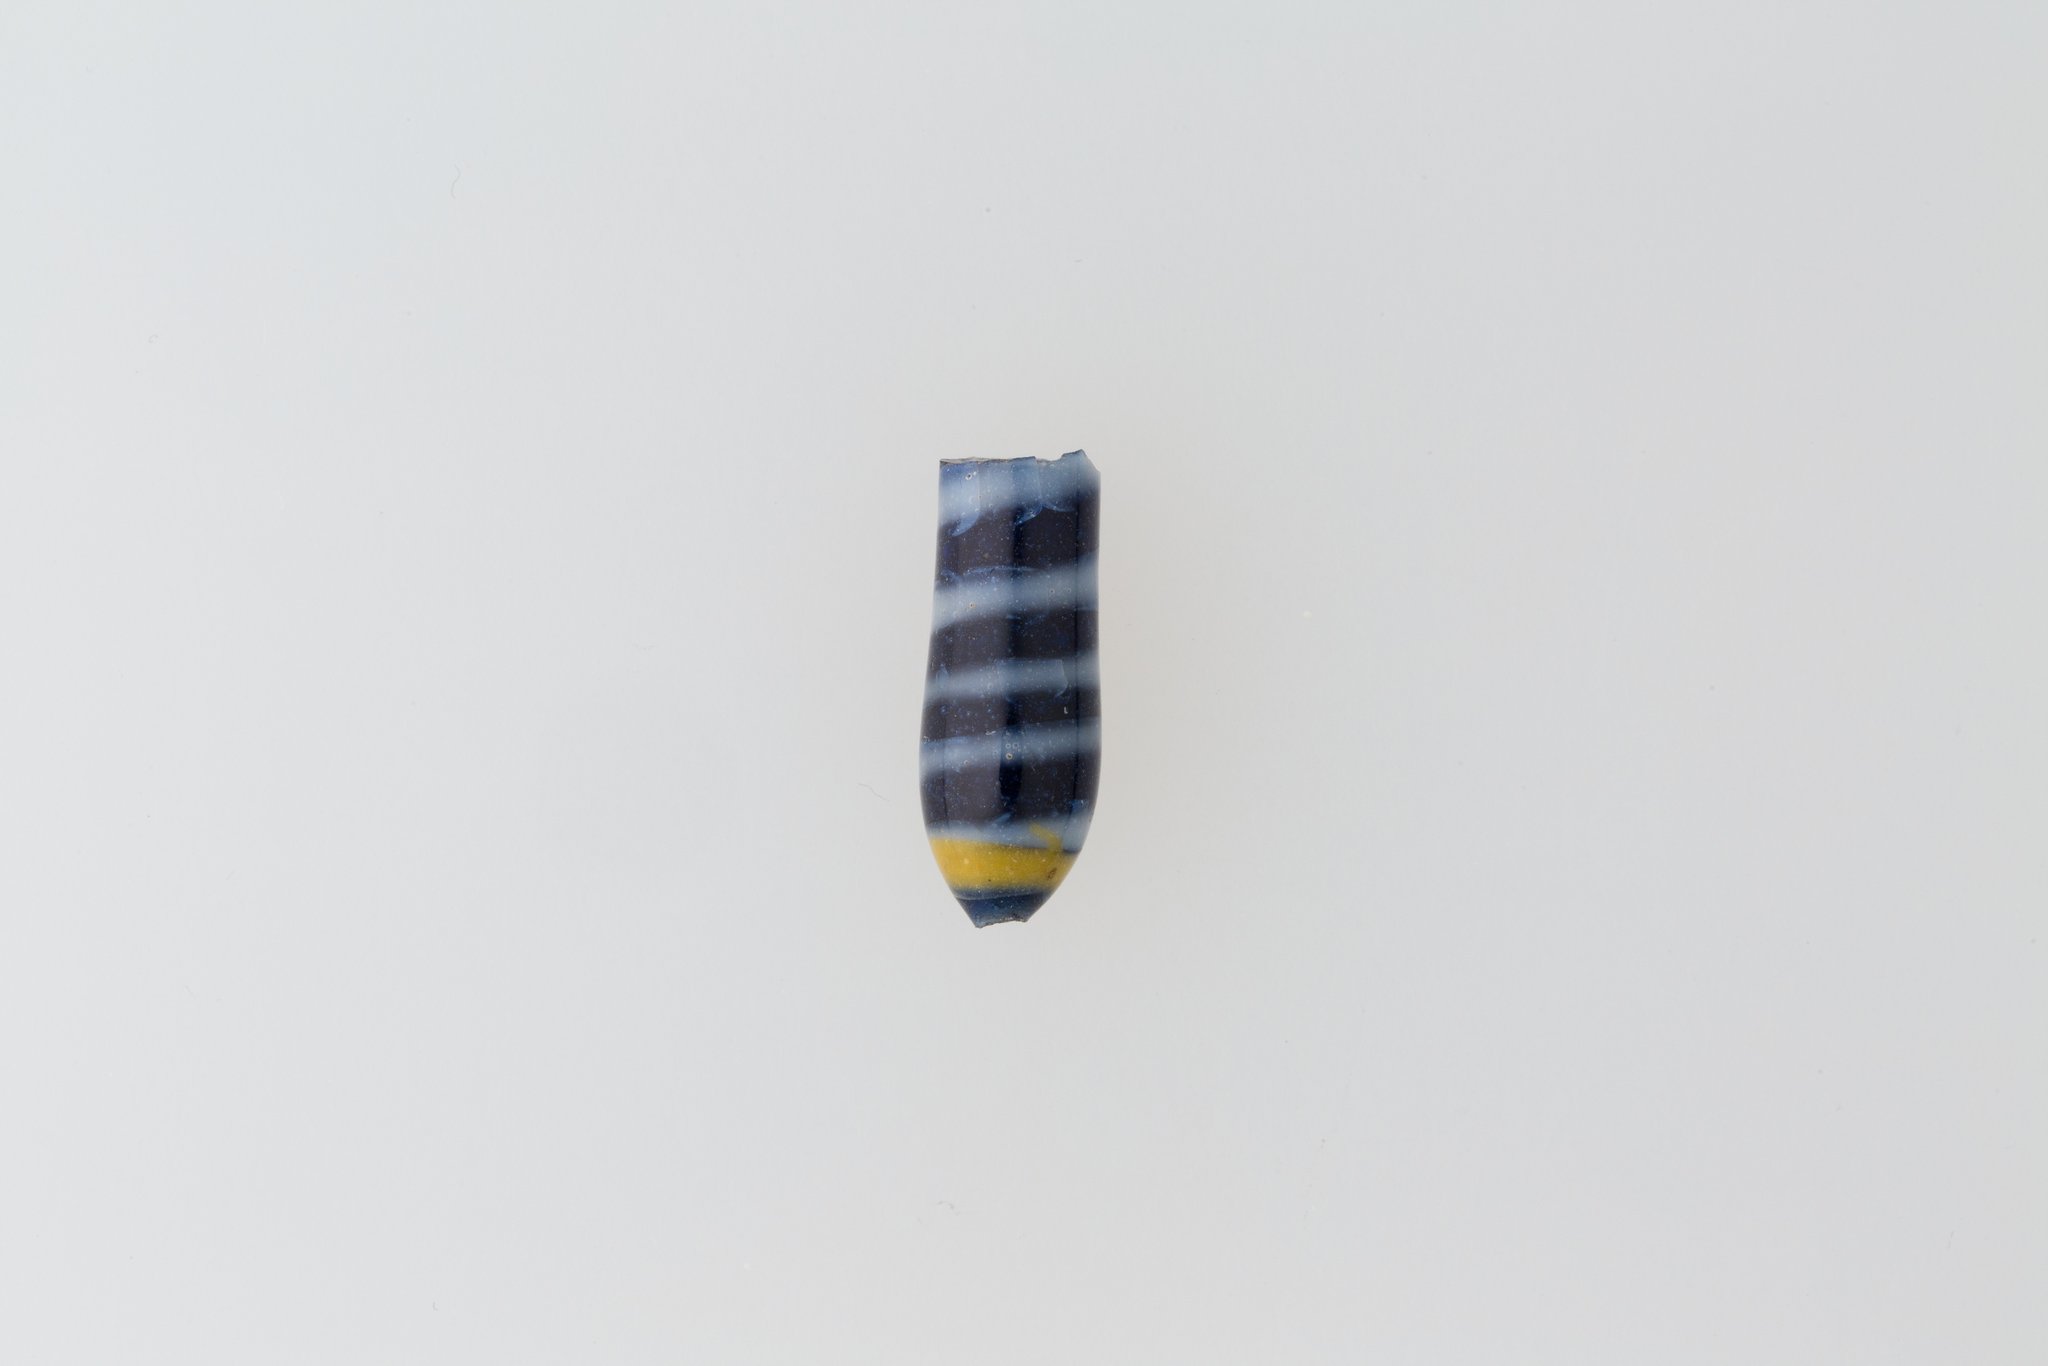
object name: part of an ear stud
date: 1390-1352 BCE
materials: glass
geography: egypt